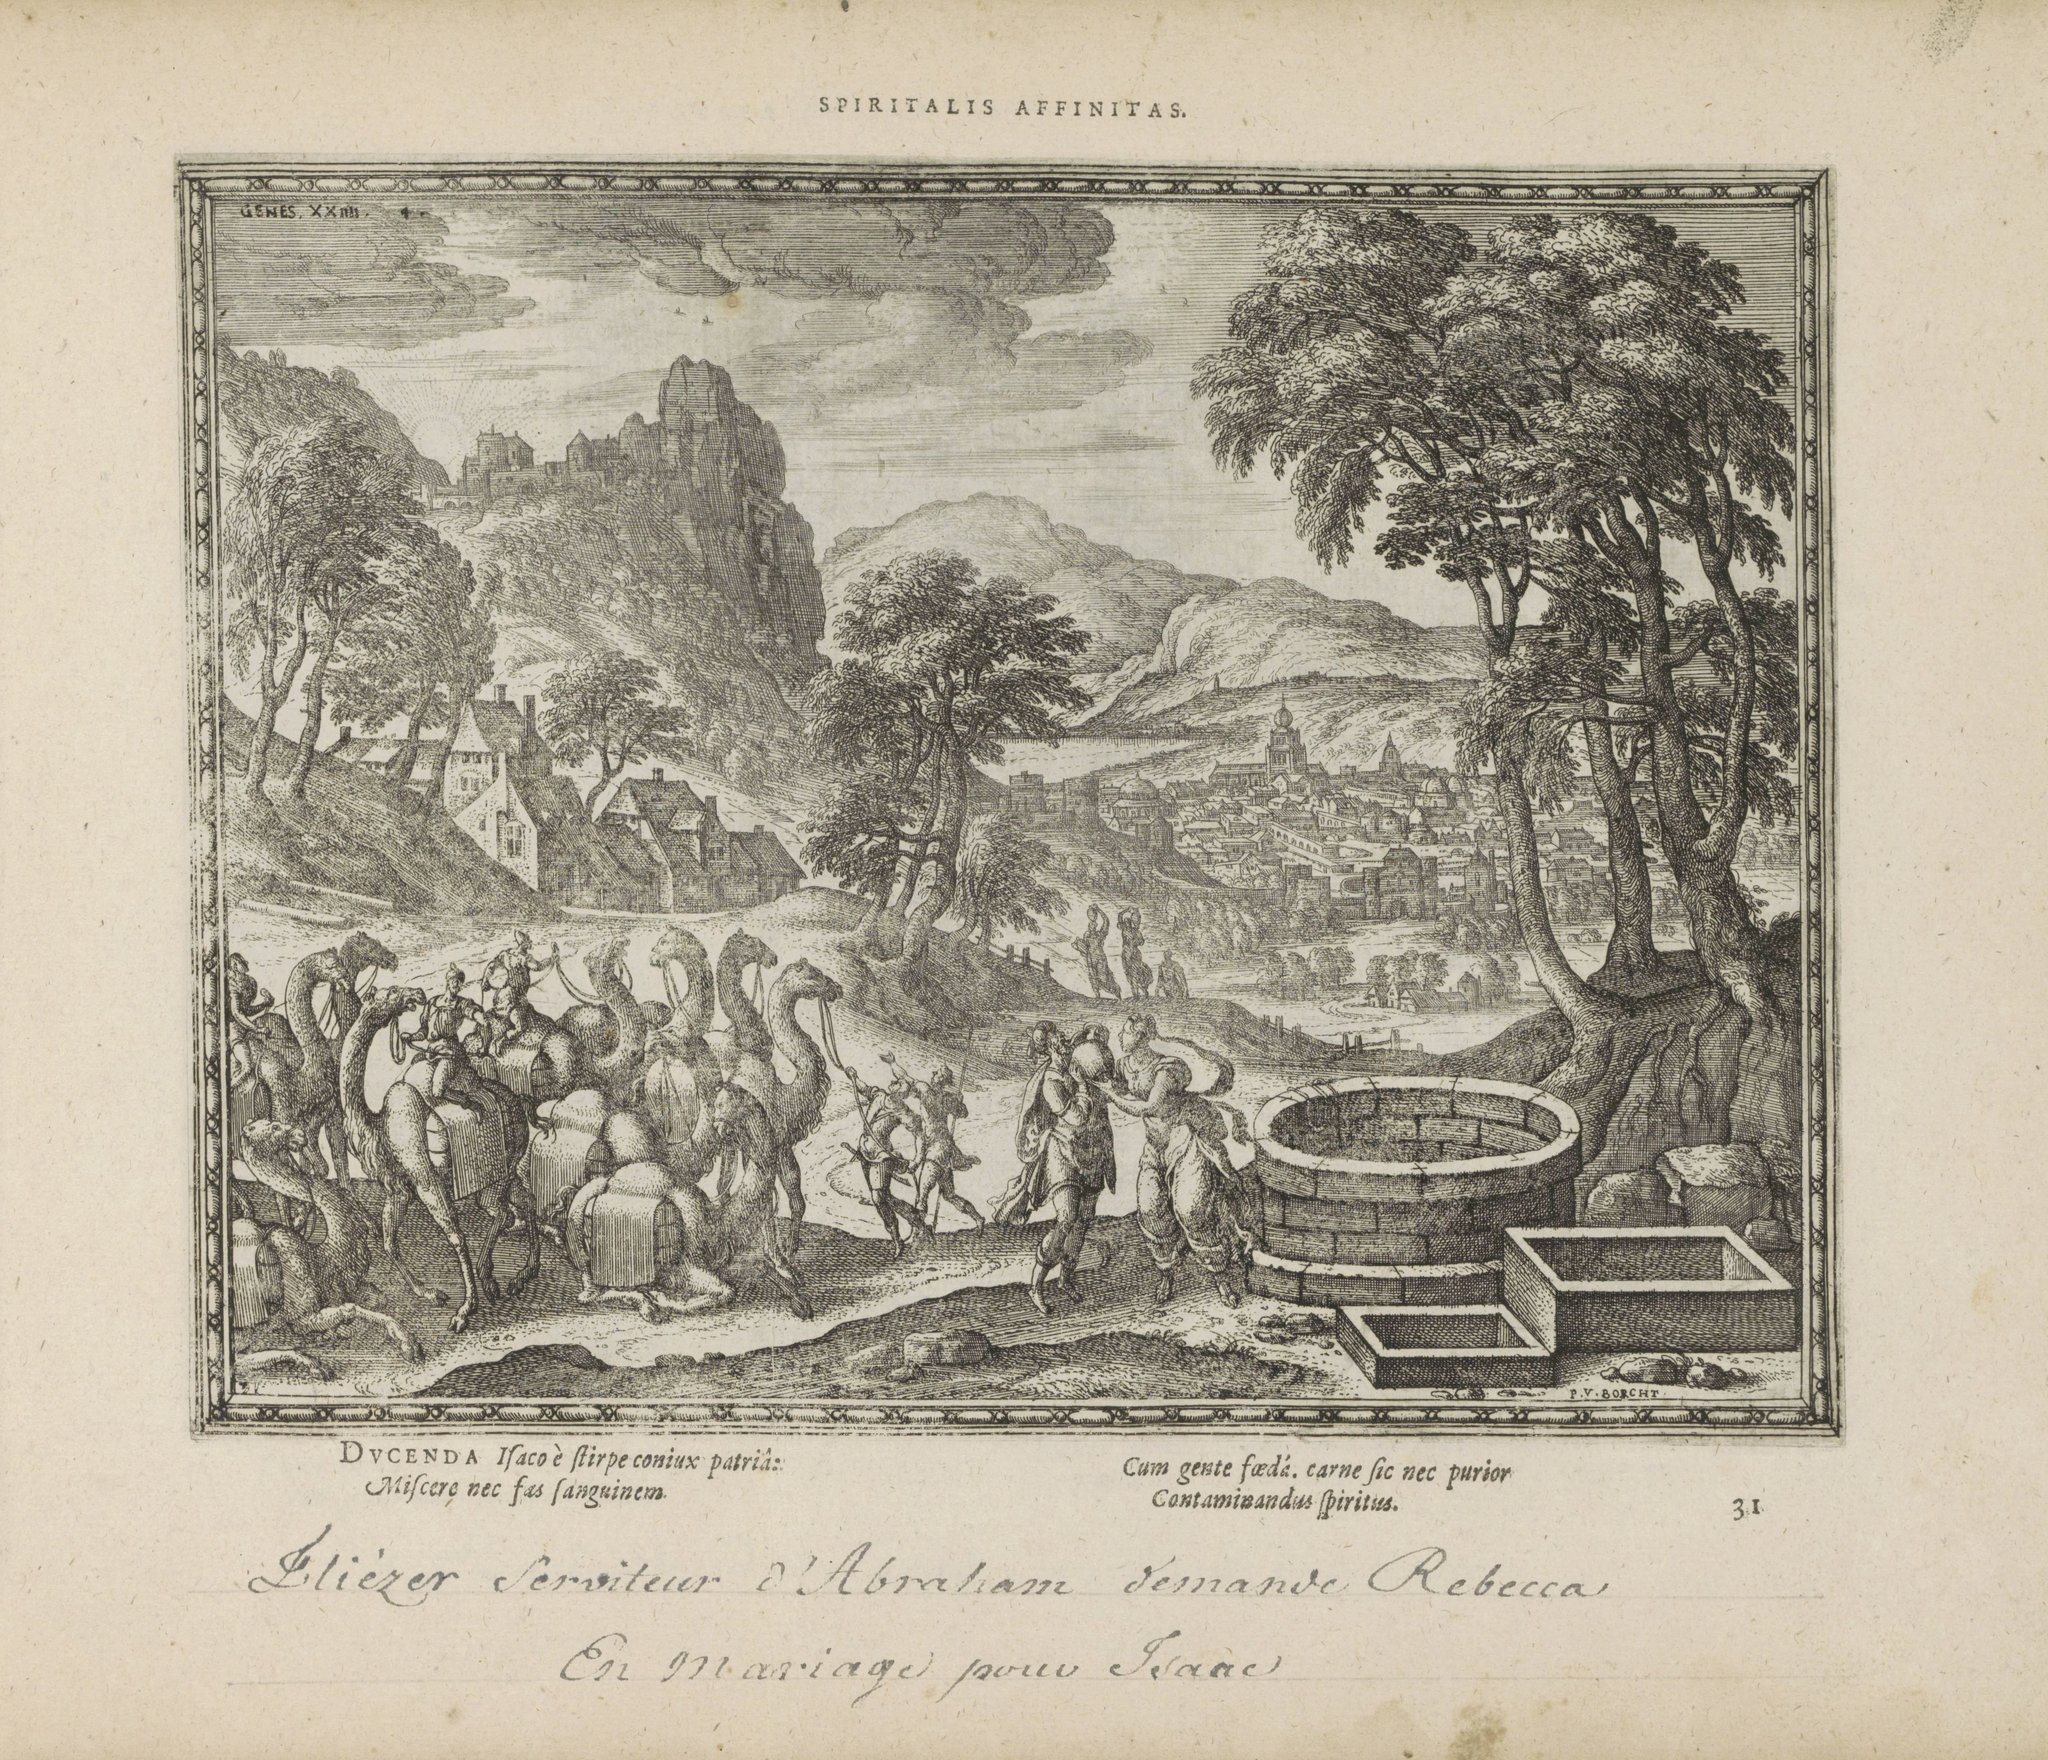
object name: print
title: Emblemata Sacra è praecipuis utriusque testamenti historiis concinnata (Oude Testament)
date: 1582-1593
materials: paper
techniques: etching, letterpress printing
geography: amsterdam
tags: hoofed animals: camel, well, rebekah offers eliezer a drink from her pitcher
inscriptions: inscription: ‘Elièzer Serviteur d'Abraham demande Rebecca en mariage pour Isaac’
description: Bij de bron laat Rebekka Eliëzer uit haar kruik drinken. Links tien kamelen. In de verte komen drie vrouwen met kruiken aanlopen (Gen. 24:4). Met een motto in het Latijn boven de voorstelling en een vierregelig onderschrift in het Latijn onder de prent. De prent maakt deel uit van een album.